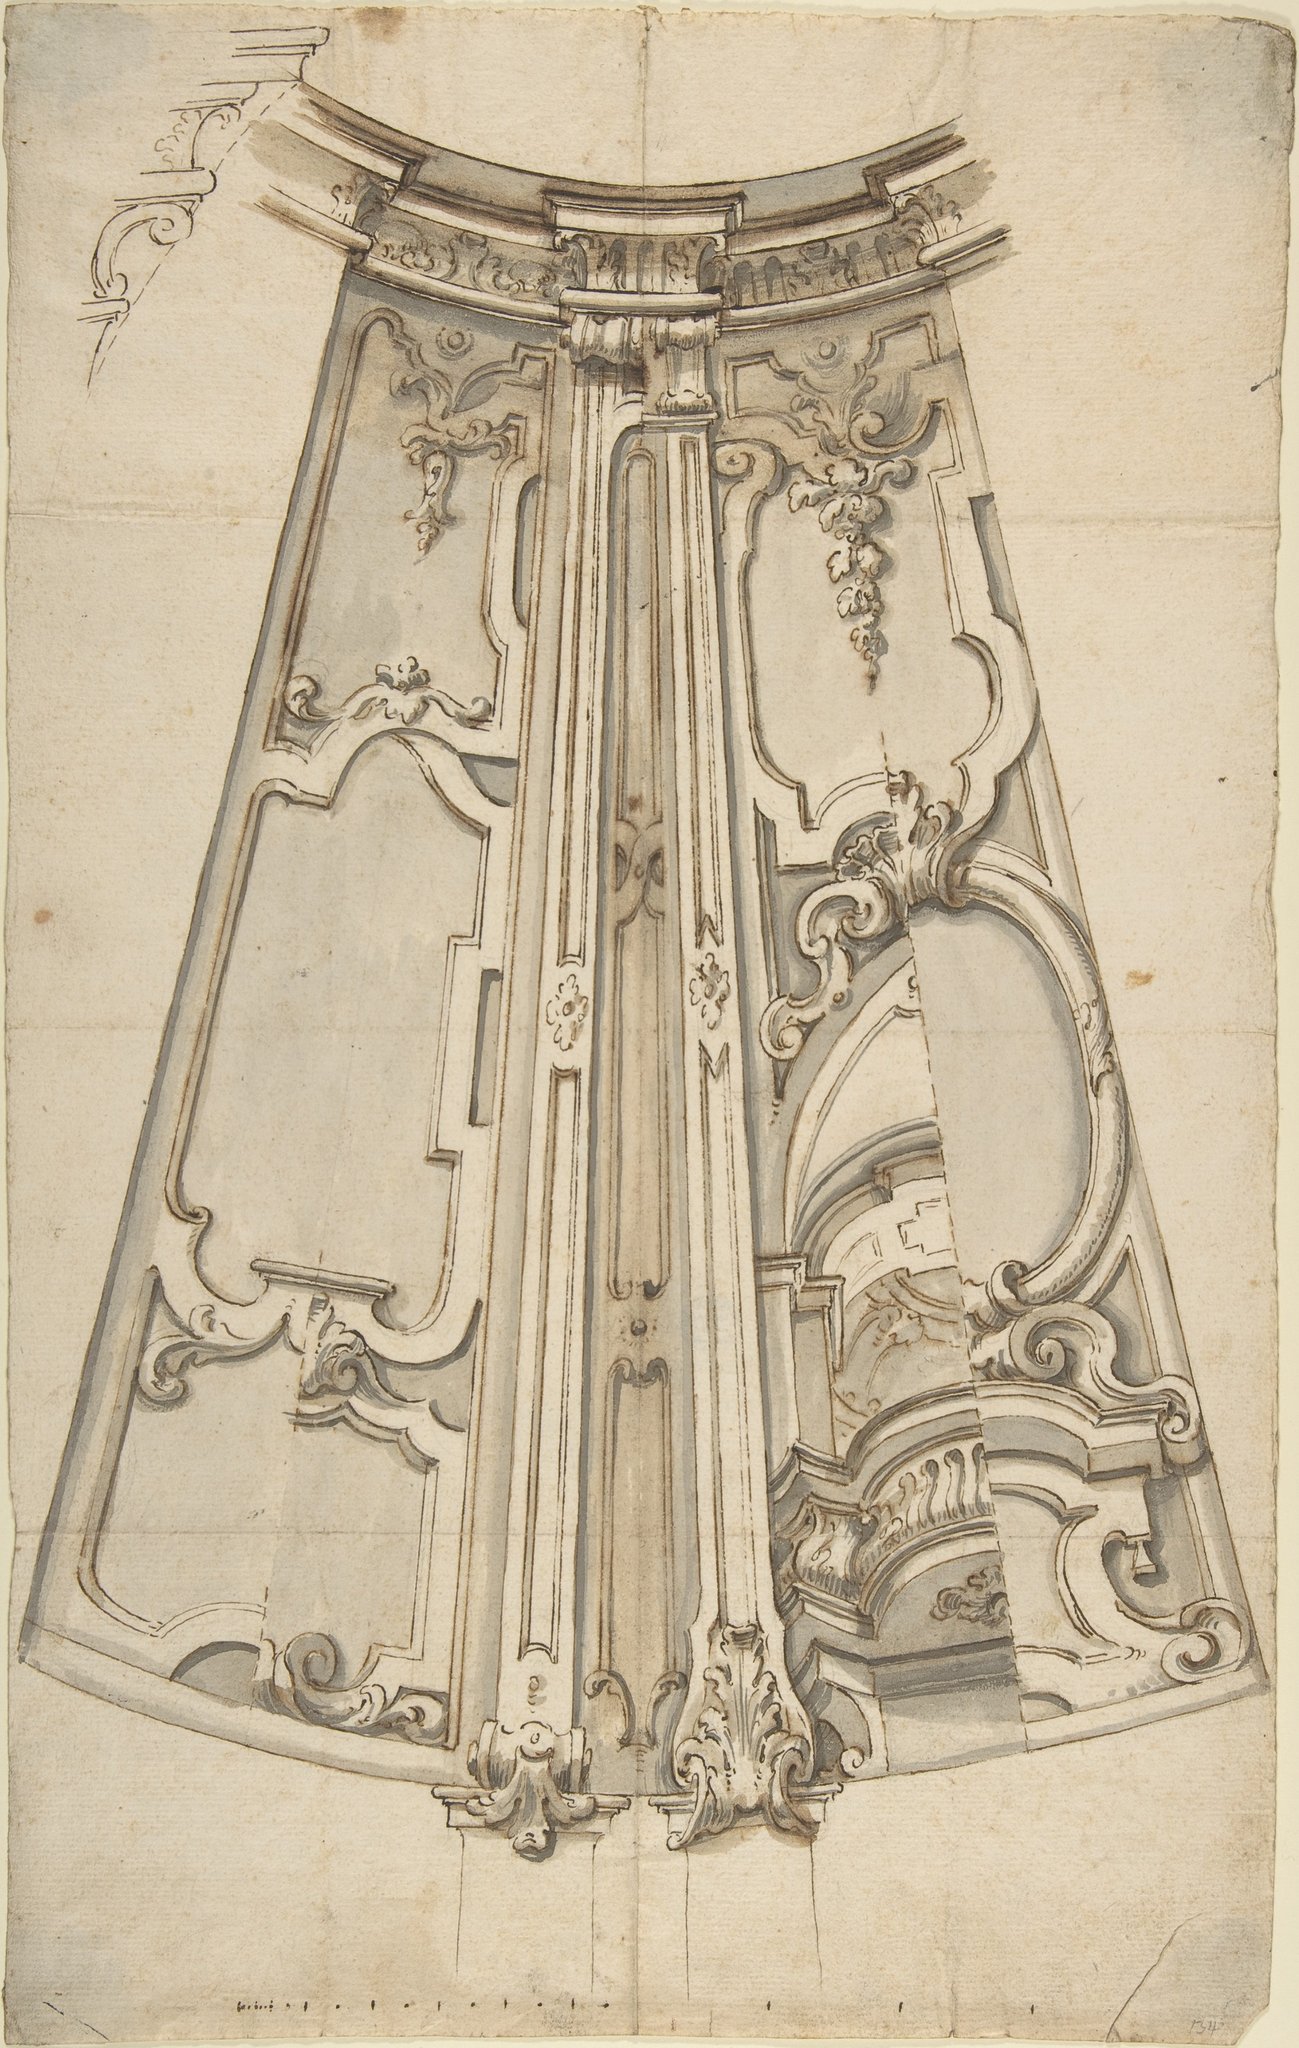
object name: drawing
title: Design for the Ornamentation of a Section of a Ceiling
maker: anonymous, italian, piedmontese, 18th century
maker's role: artist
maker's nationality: italian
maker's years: 1700-1800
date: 1700-1780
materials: graphite, ink, drawing material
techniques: brush, pen, wash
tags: architecture,ornament